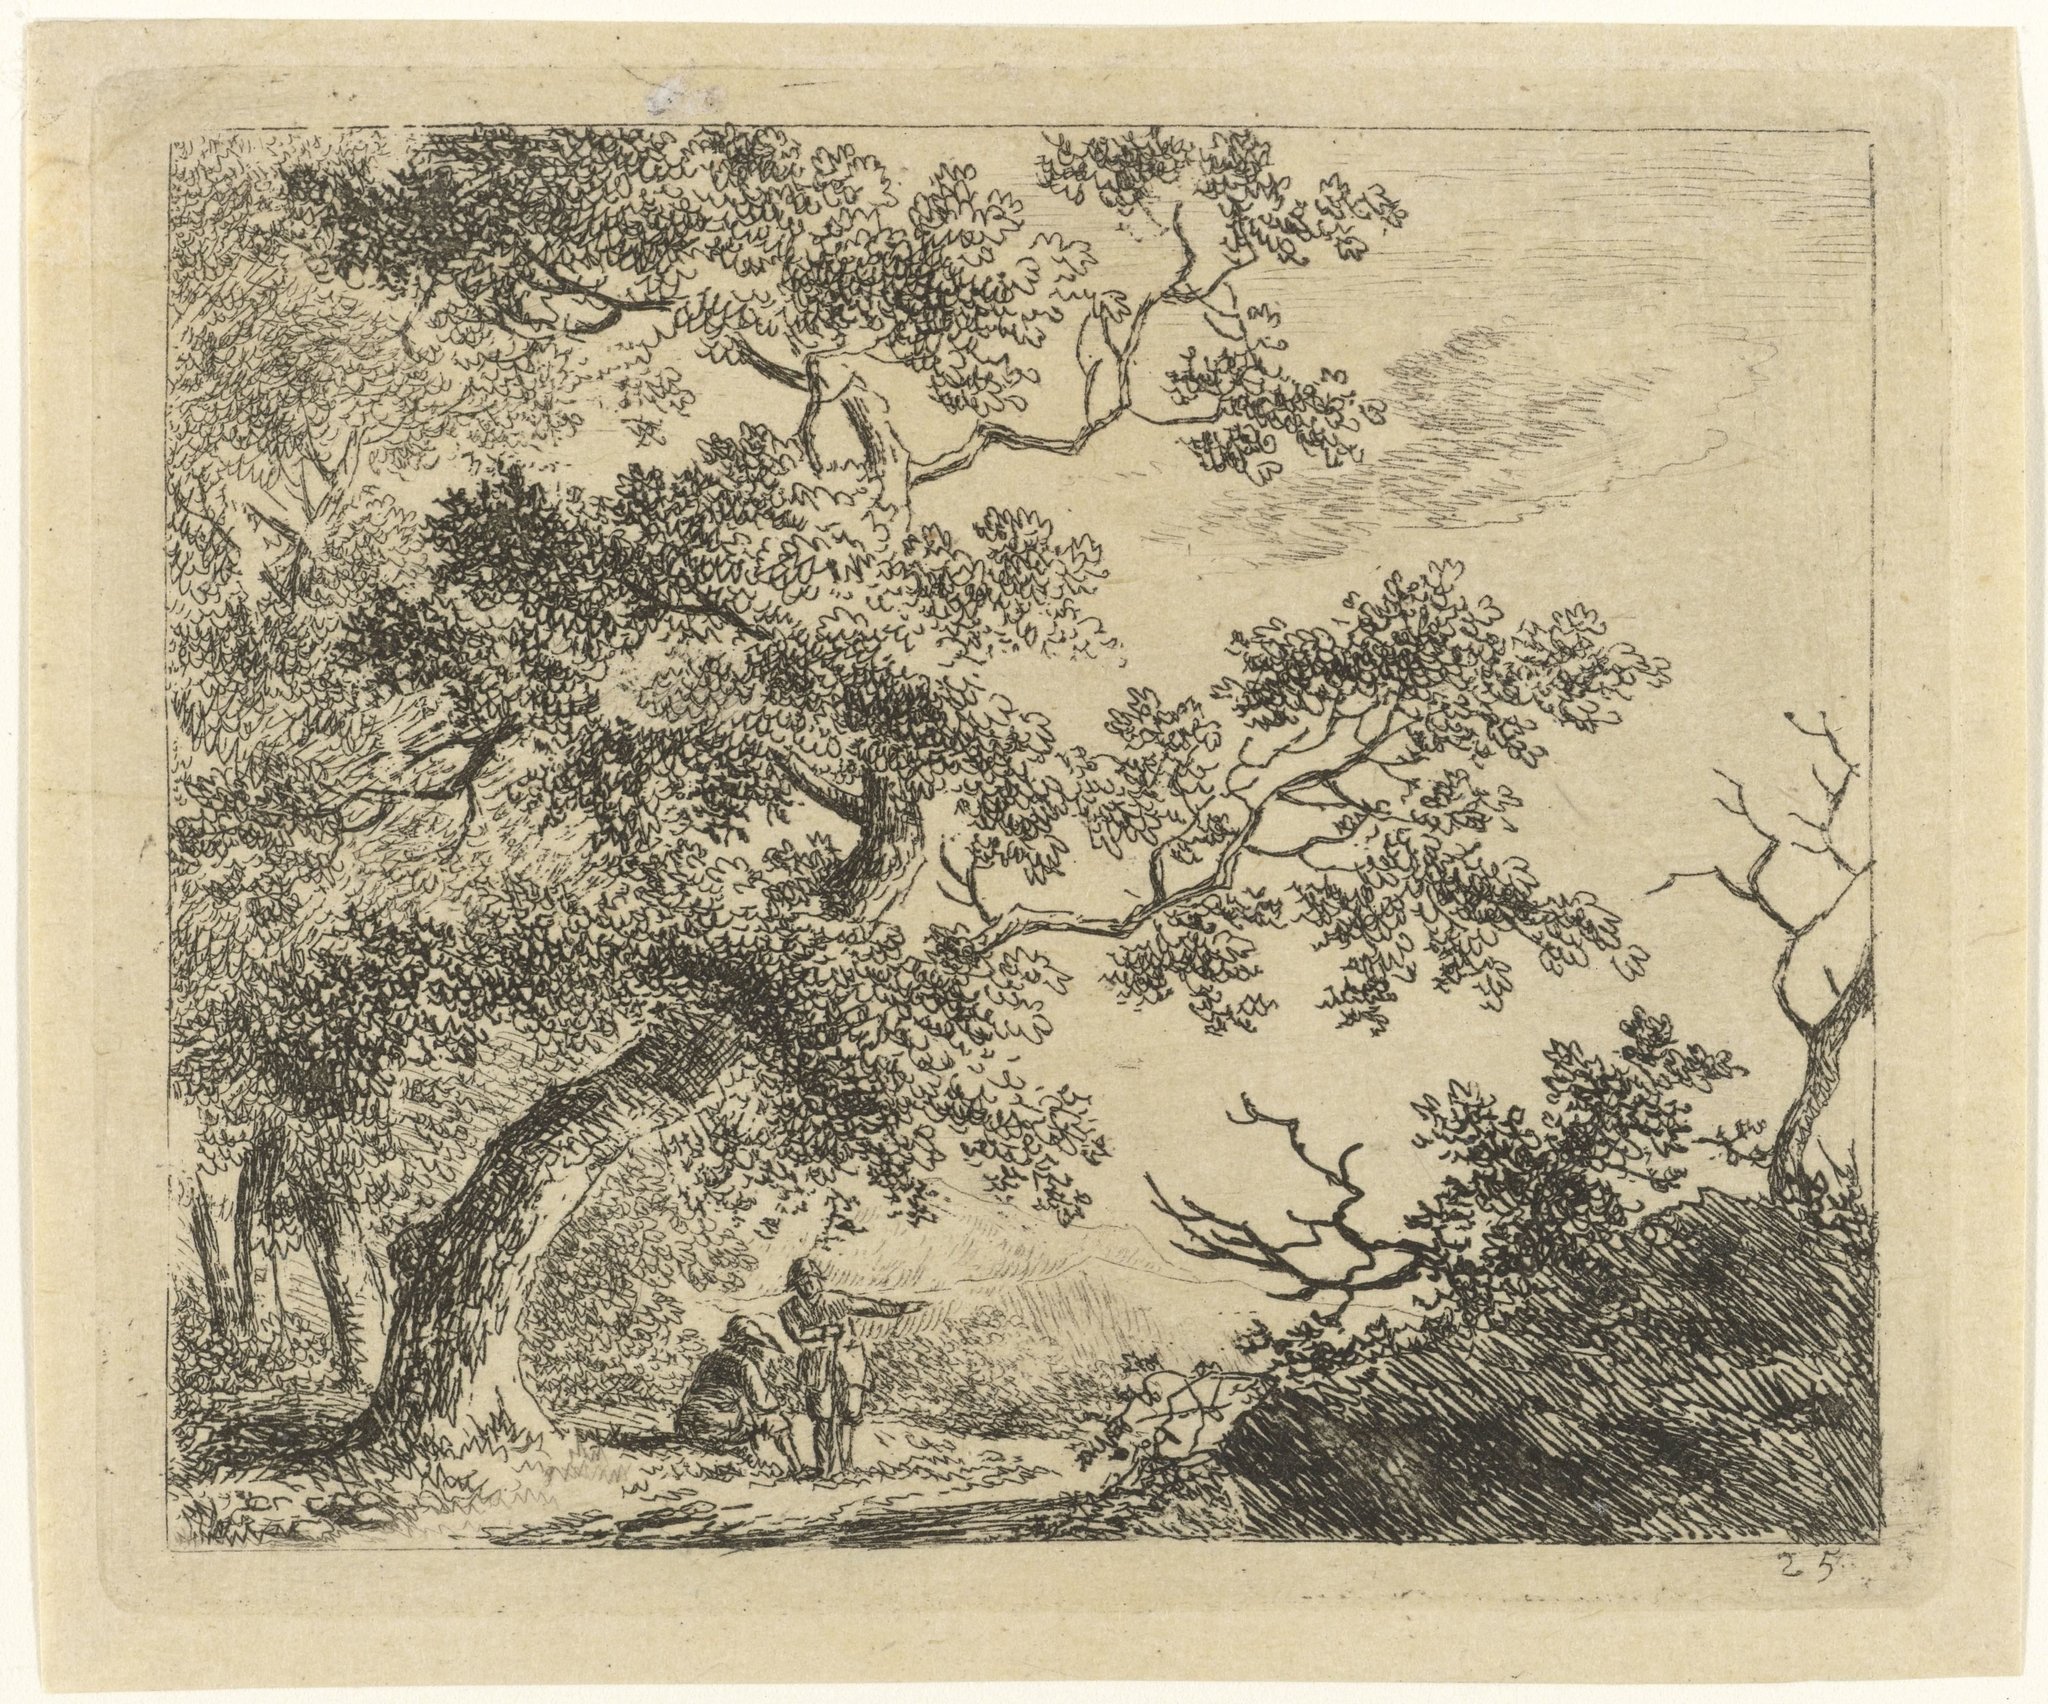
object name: print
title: Boslandschap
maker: johannes janson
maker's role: draughtsman, painter, print maker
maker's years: 1729-1784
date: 1761-1784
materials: paper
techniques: etching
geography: leiden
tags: forest, wood (+ landscape with figures, staffage)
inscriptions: collector's mark: Lugt 240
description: Boslandschap met twee figuren onder een boom, van wie één zittend en één staand. Rechtsonder: 25. Prent uit een serie met landschappen.